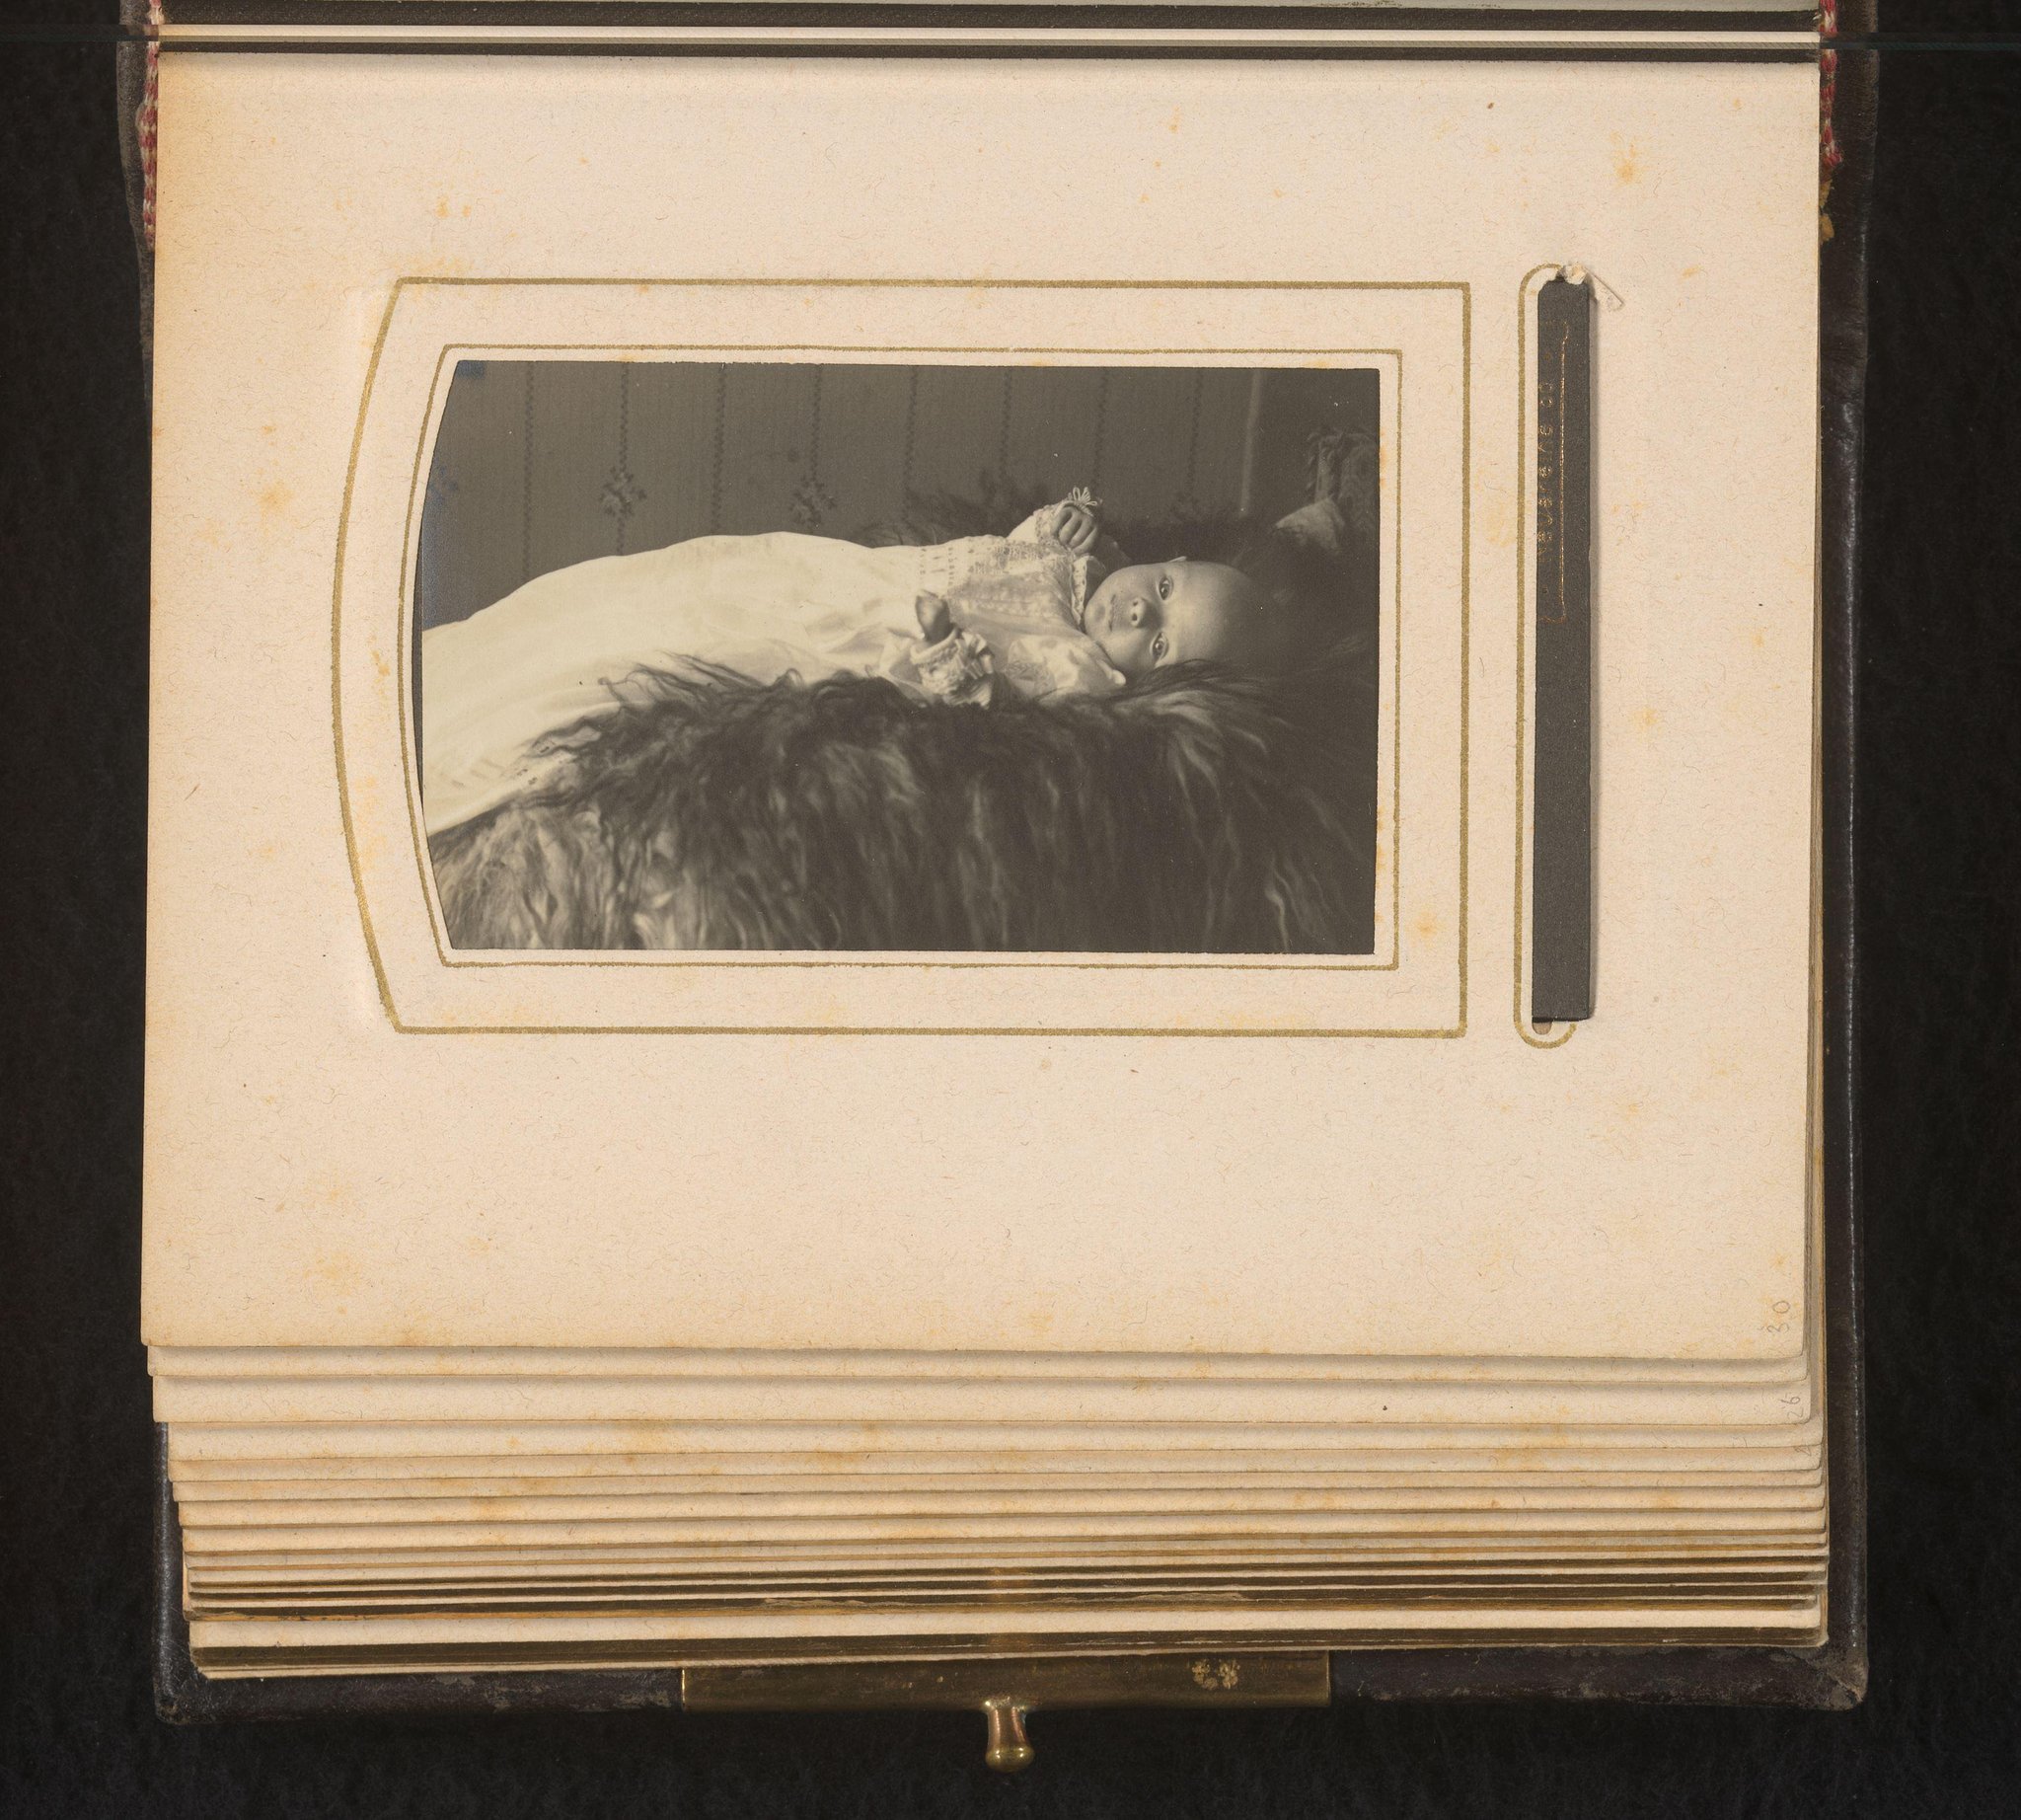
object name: carte de visite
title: Portret van een baby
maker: emil vogt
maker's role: fotograaf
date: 1880-1910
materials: cardboard, photographic support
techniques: gelatin silver print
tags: historical persons, infant, baby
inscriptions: annotation: ‘Irmgard [...]/ 1/4 Jahr alt.’, inscription: ‘Emil Vogt/ Cuxhaven/ Neuereihe 36’